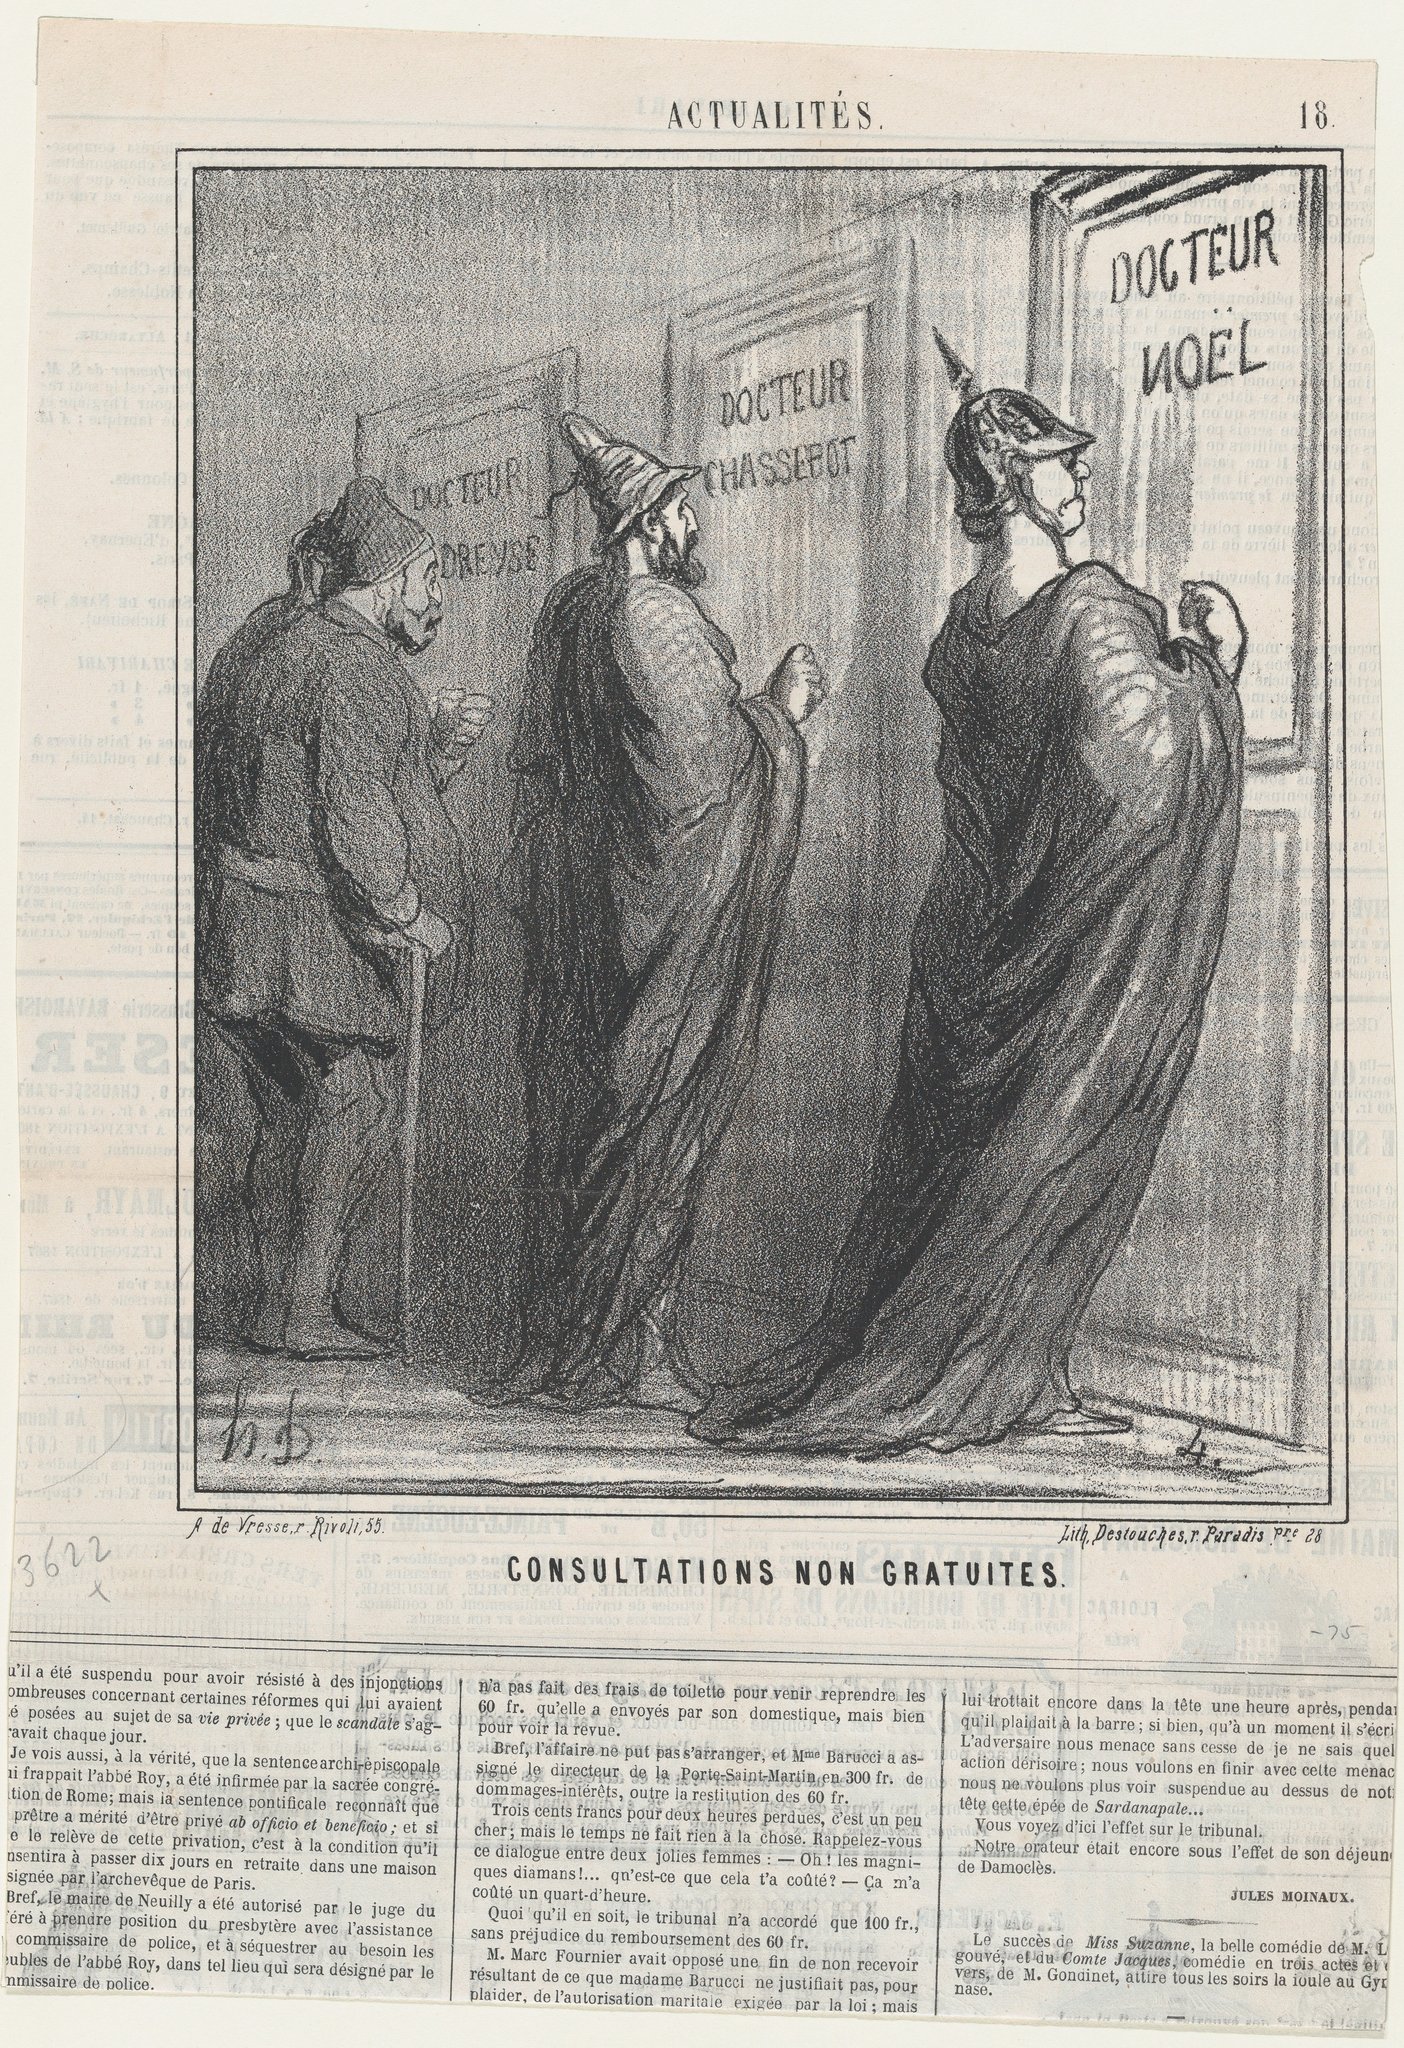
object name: print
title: Consultations that are not free of charge, from 'News of the day,' published in Le Charivari, February 3, 1868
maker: honoré daumier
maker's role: artist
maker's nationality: french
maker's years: 1808-1879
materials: paper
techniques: lithograph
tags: satire,men